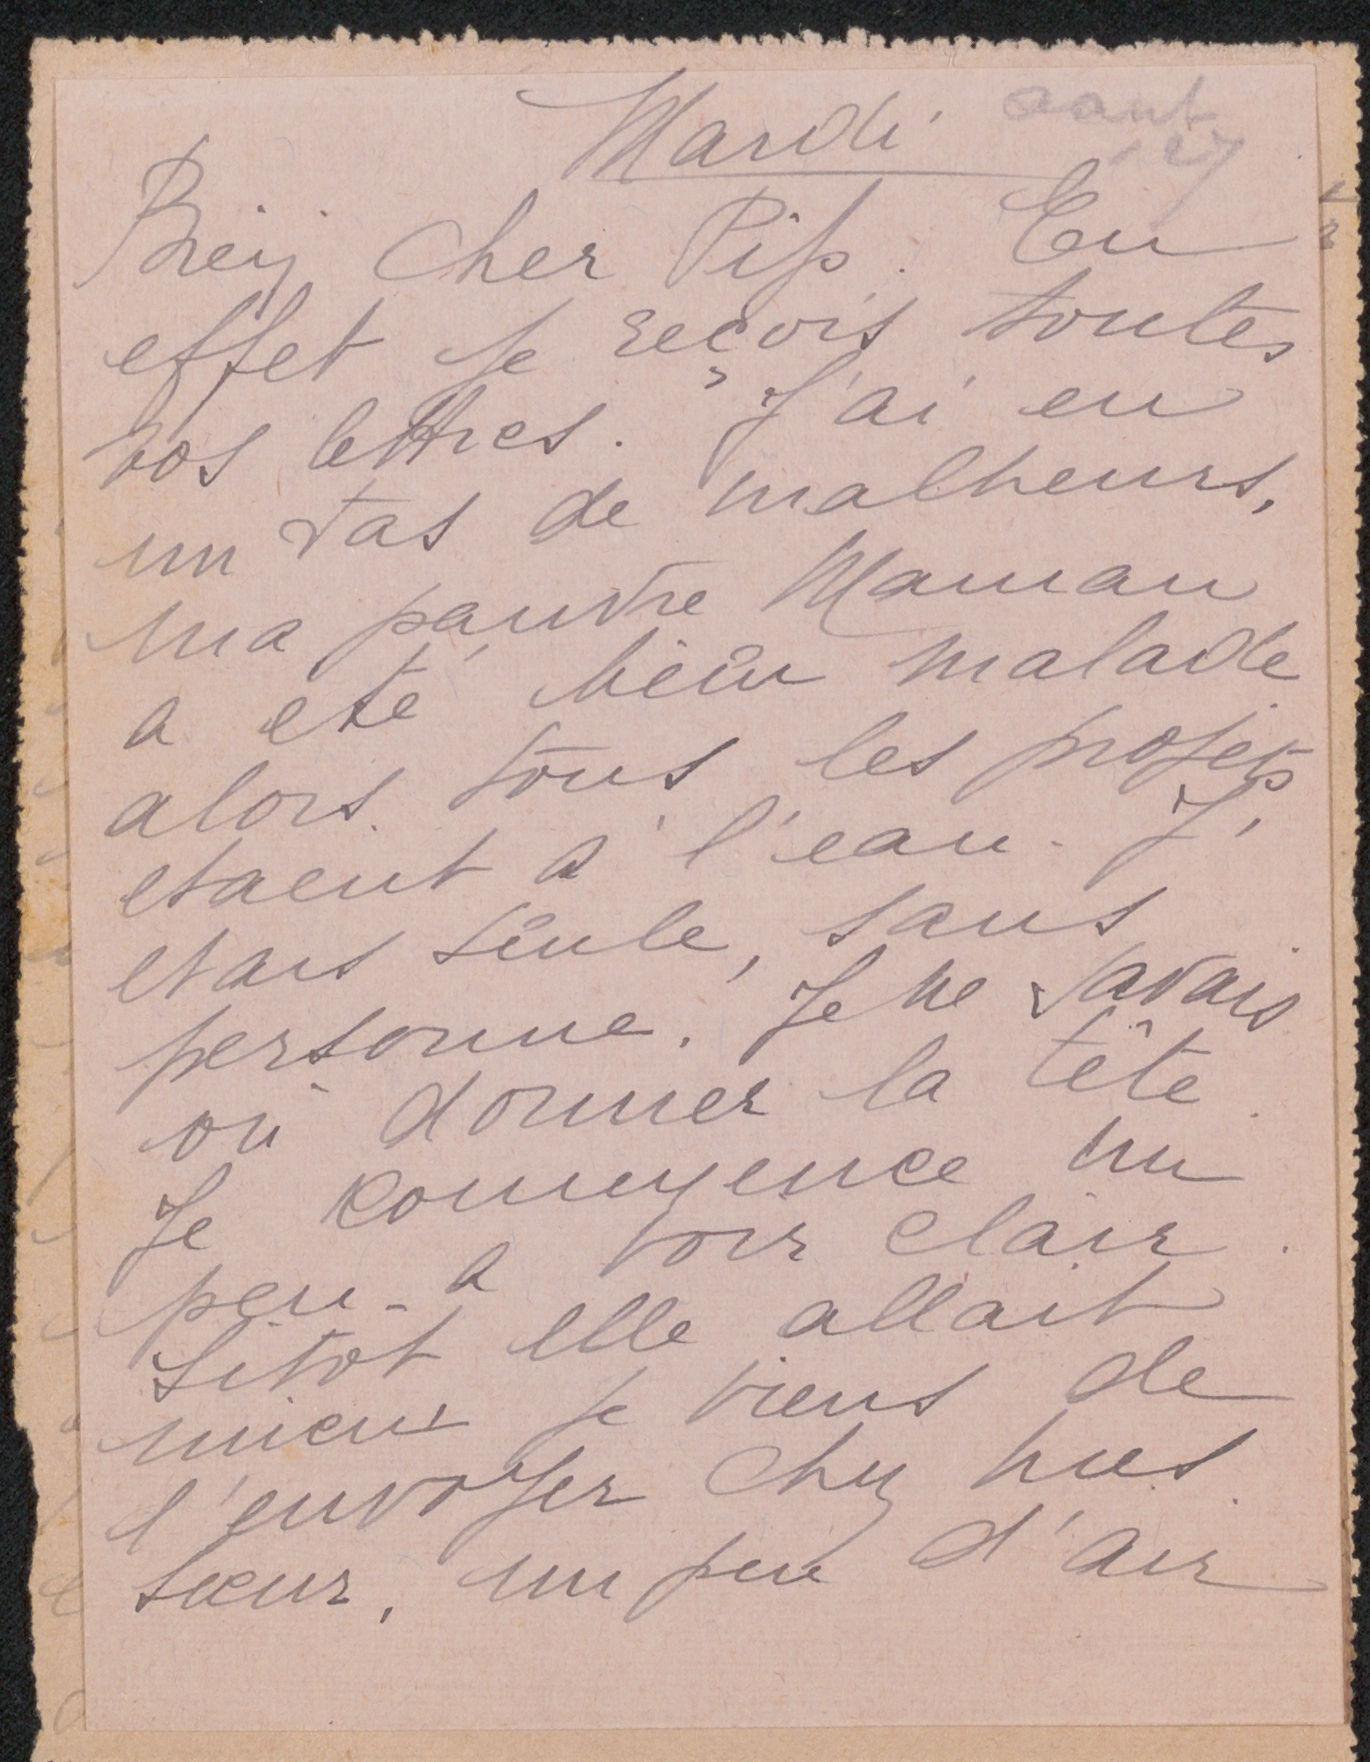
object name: letter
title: Brief aan Philip Zilcken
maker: rose imel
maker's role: draughtsman, painter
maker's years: 1901-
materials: ink, paper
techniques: pen, writing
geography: paris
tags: the hague, painter, draughtsman, philip zilcken, the graphic arts, diseases, belgium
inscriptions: collector's mark: ‘RPK’